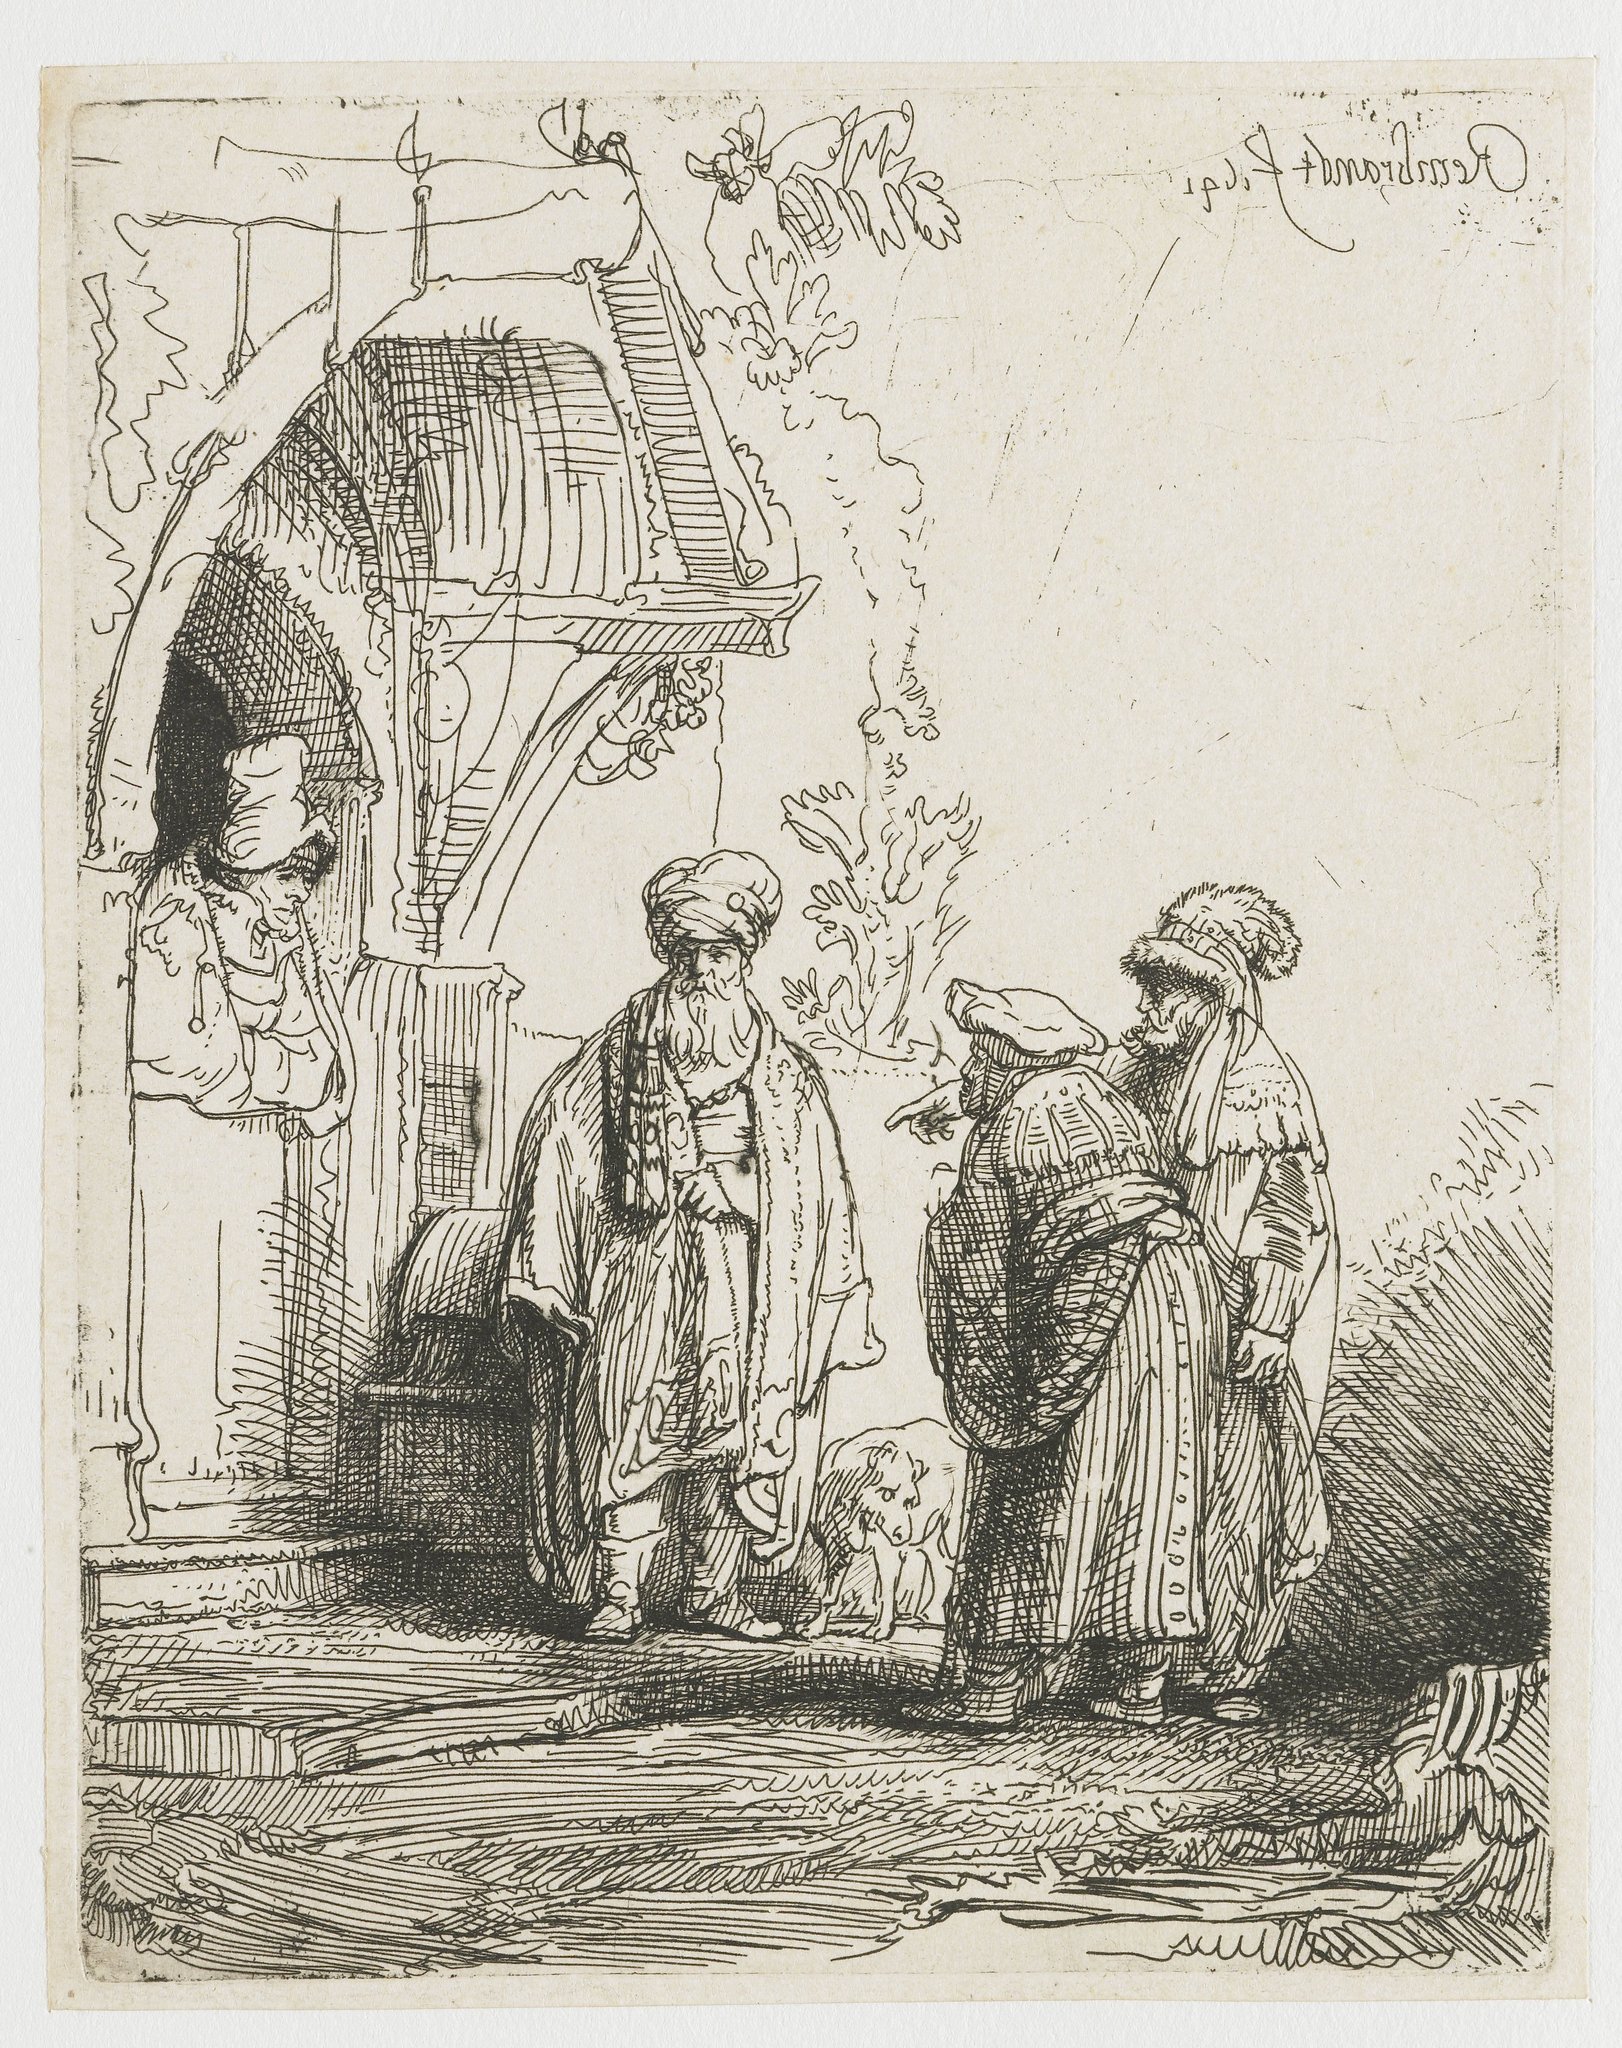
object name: print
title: Three oriental figures (Jacob and Laban?)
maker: rembrandt van rijn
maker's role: draughtsman, painter, print maker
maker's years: 1606-1669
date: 1641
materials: paper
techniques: drypoint, etching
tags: the partnership with laban ~ story of jacob (genesis 30:25-43)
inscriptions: signature and date: ‘Rembrandt f 1641 (spiegelbeeldig)’, mark: Lugt 2228